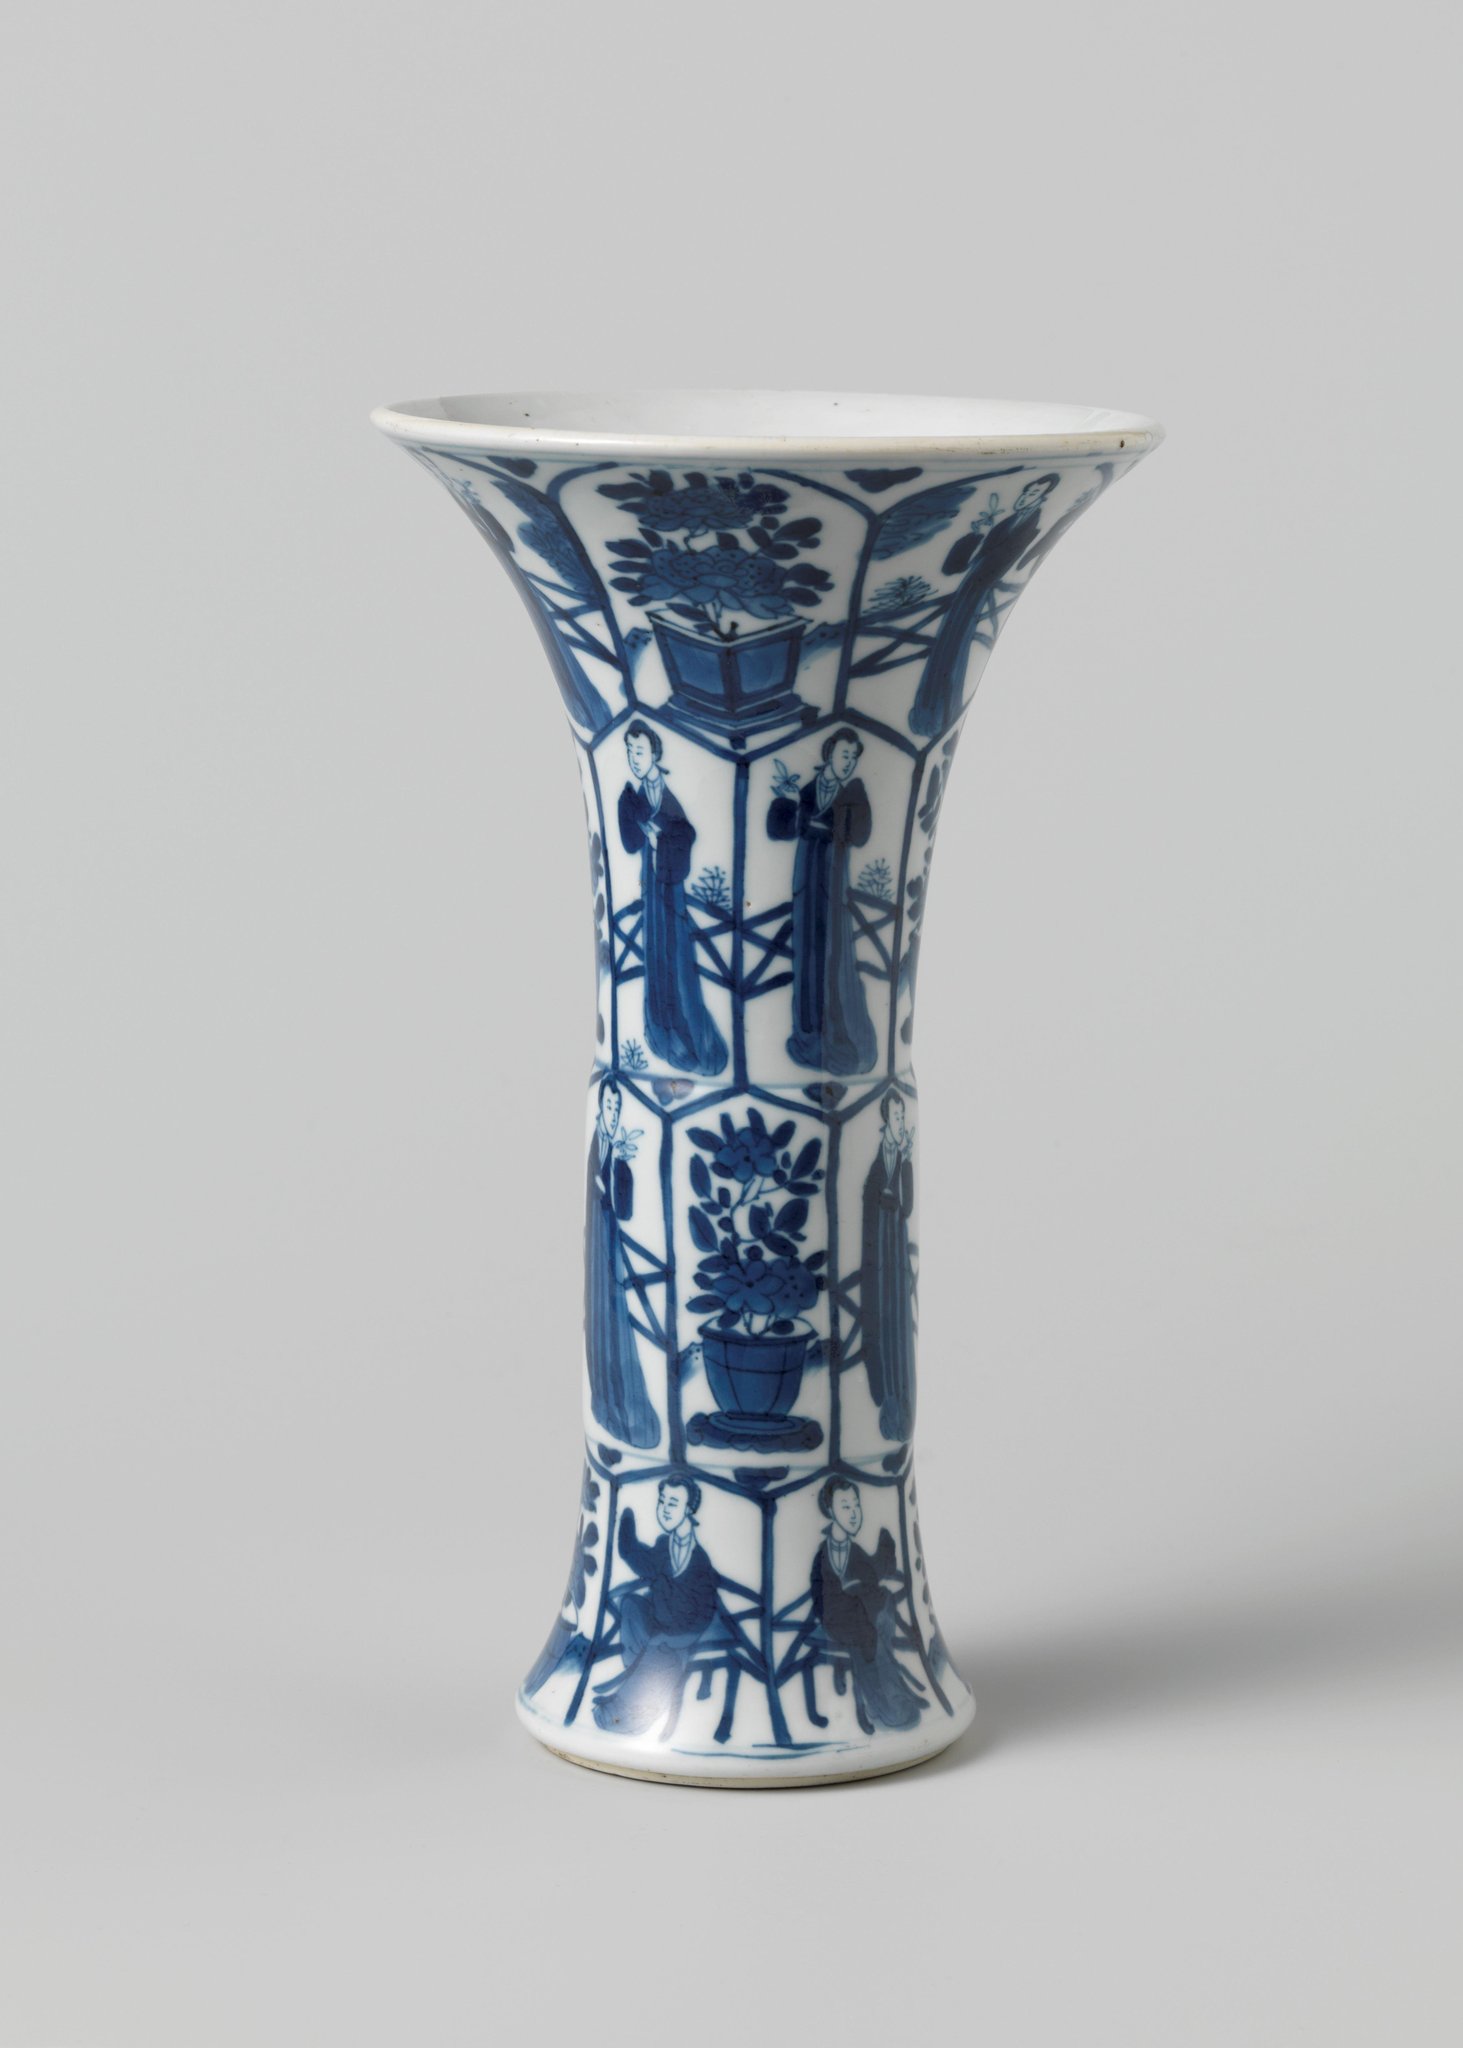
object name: vase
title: Beakervase with women and flower pots in panels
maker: Anonymous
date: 1680-1720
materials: cobalt, glaze, paint, porcelain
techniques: firing, turning, vitrification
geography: china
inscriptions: mark: ‘玉 Yù’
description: Trompetvormige bekervaas van porselein, beschilderd in onderglazuur blauw. De wand is verdeeld in vier rijen met zeshoekige vakken met daarin afwisselend een vrouw (lange lijs) in een omheinde tuin en een bloemenvaas in een landschap. Gemerkt op de onderzijde met het karakter 'yù', jade, in een dubbele cirkel. Een barst in de rand. Onderdeel van een kaststel met nummer AK-RBK-16290. Blauw-wit.